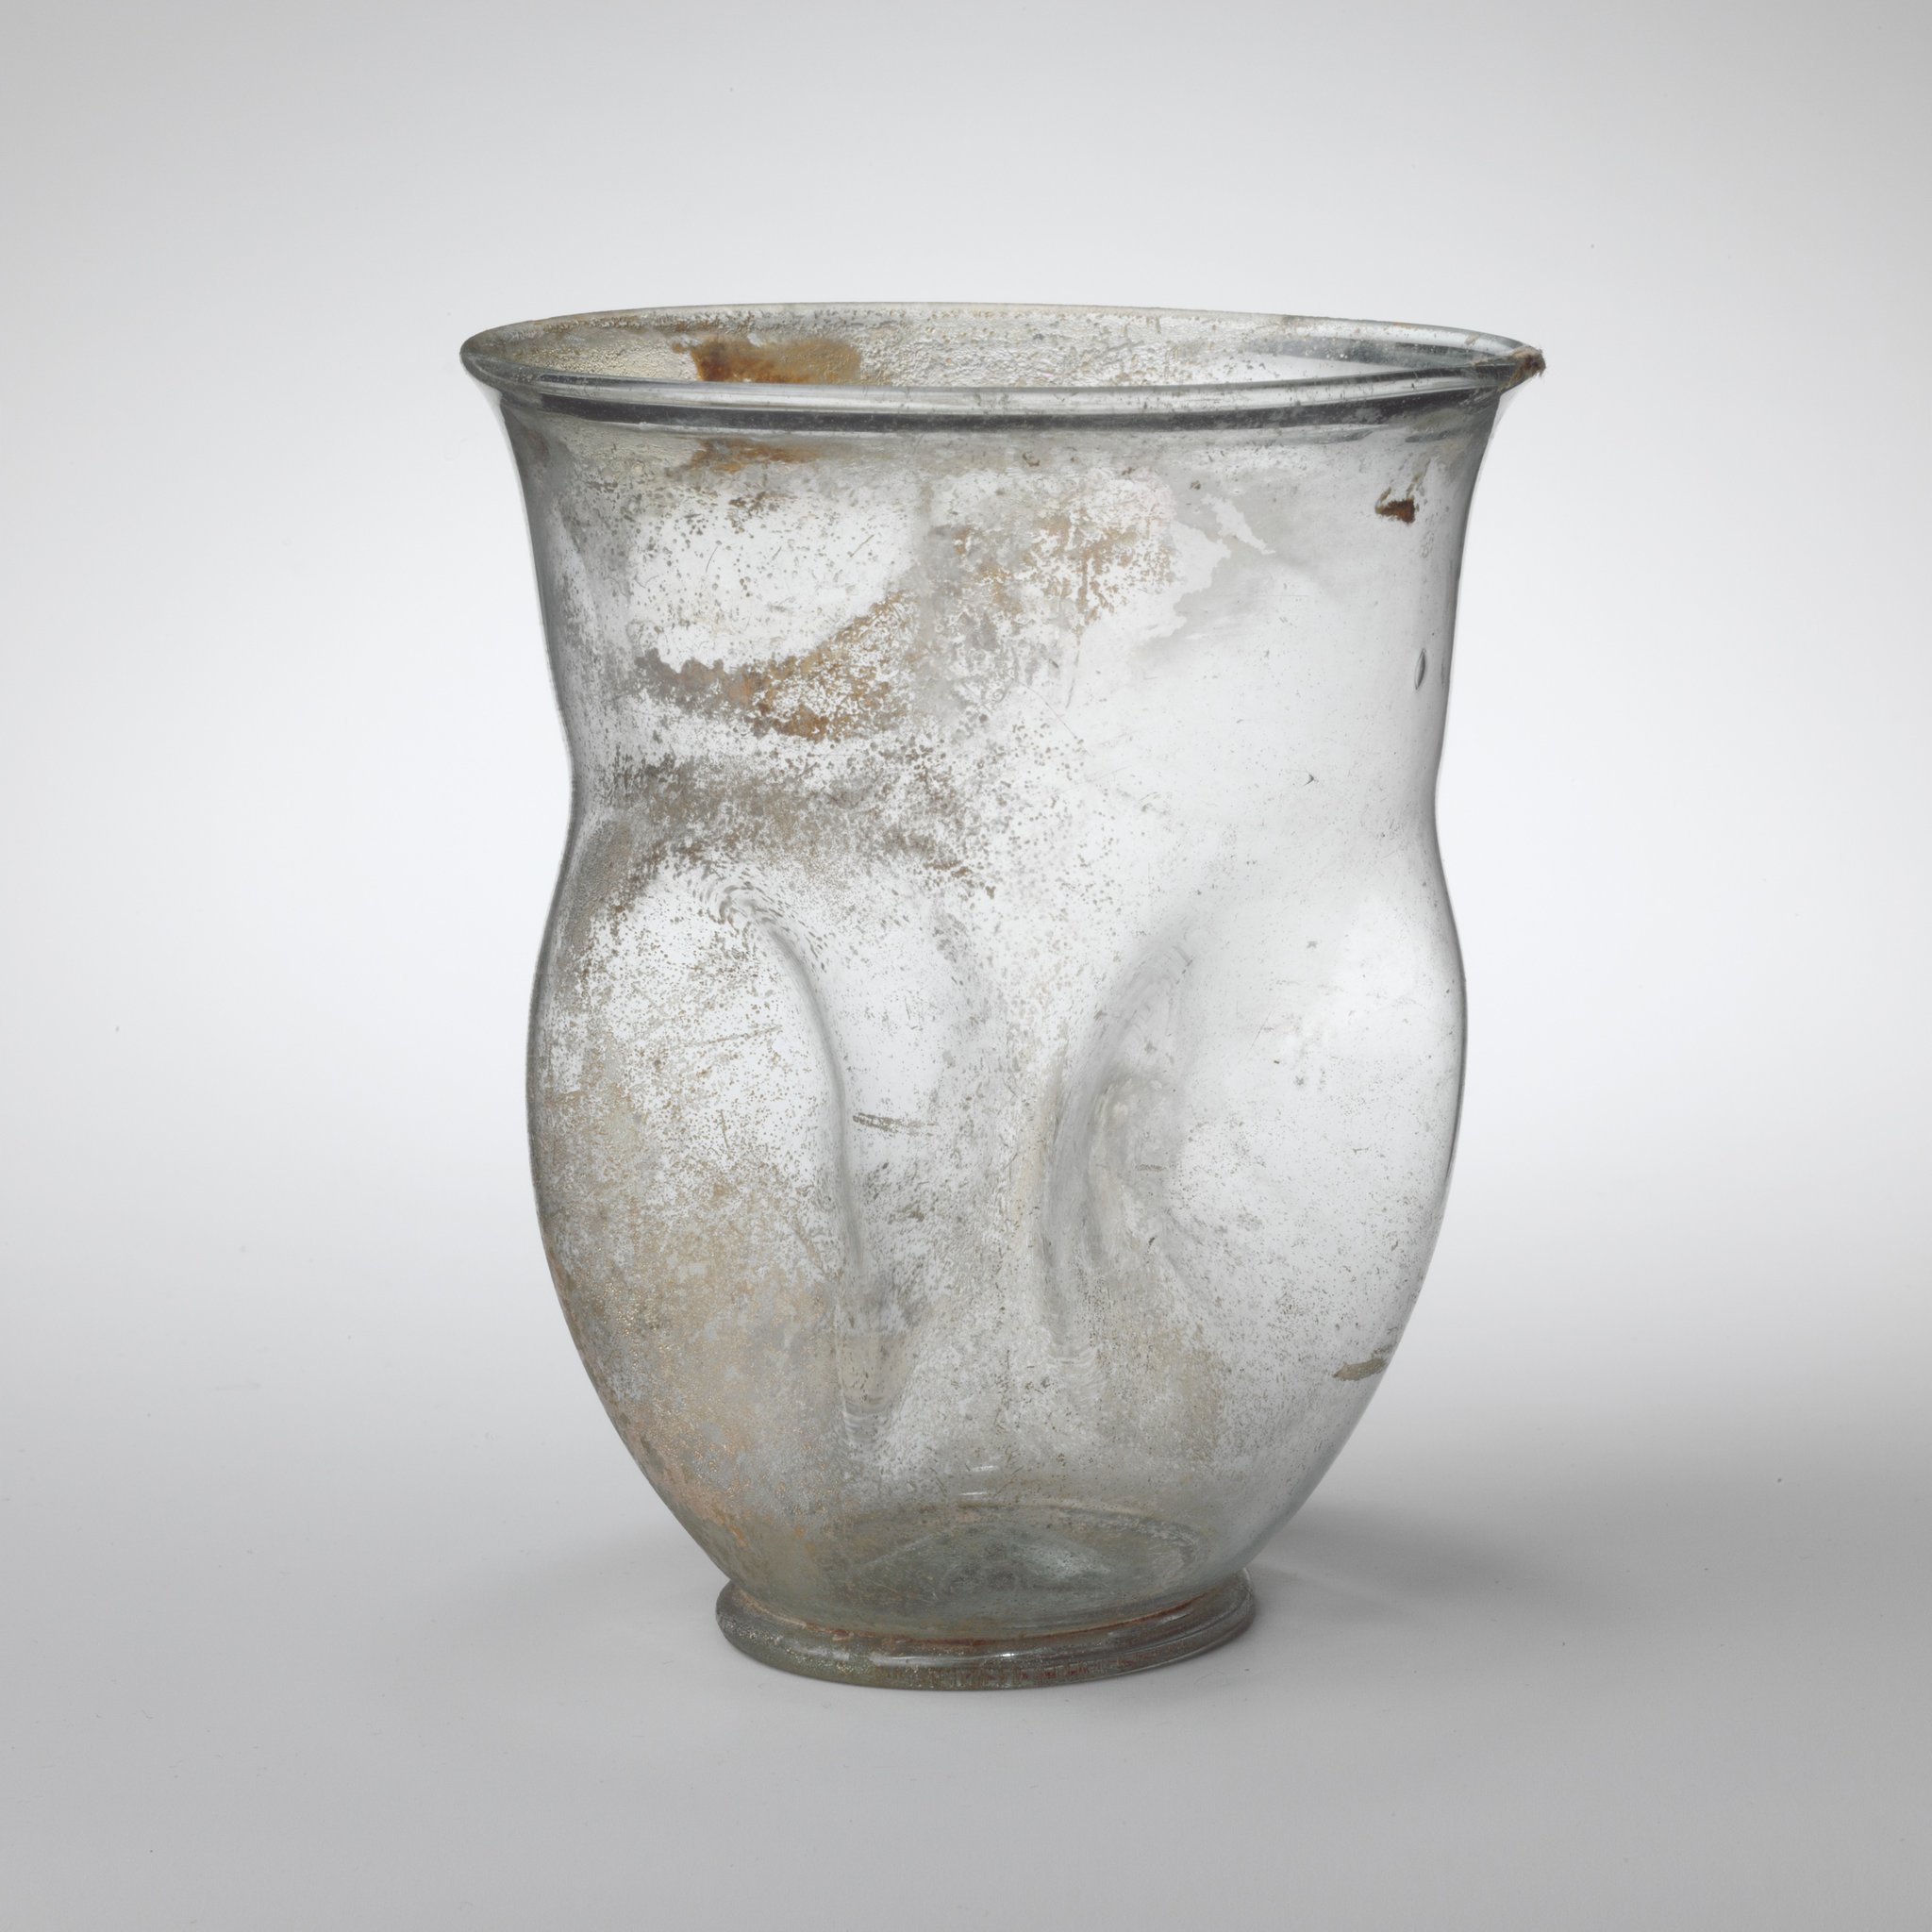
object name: beaker, indented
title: Glass beaker with indented sides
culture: roman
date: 101-300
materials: glass